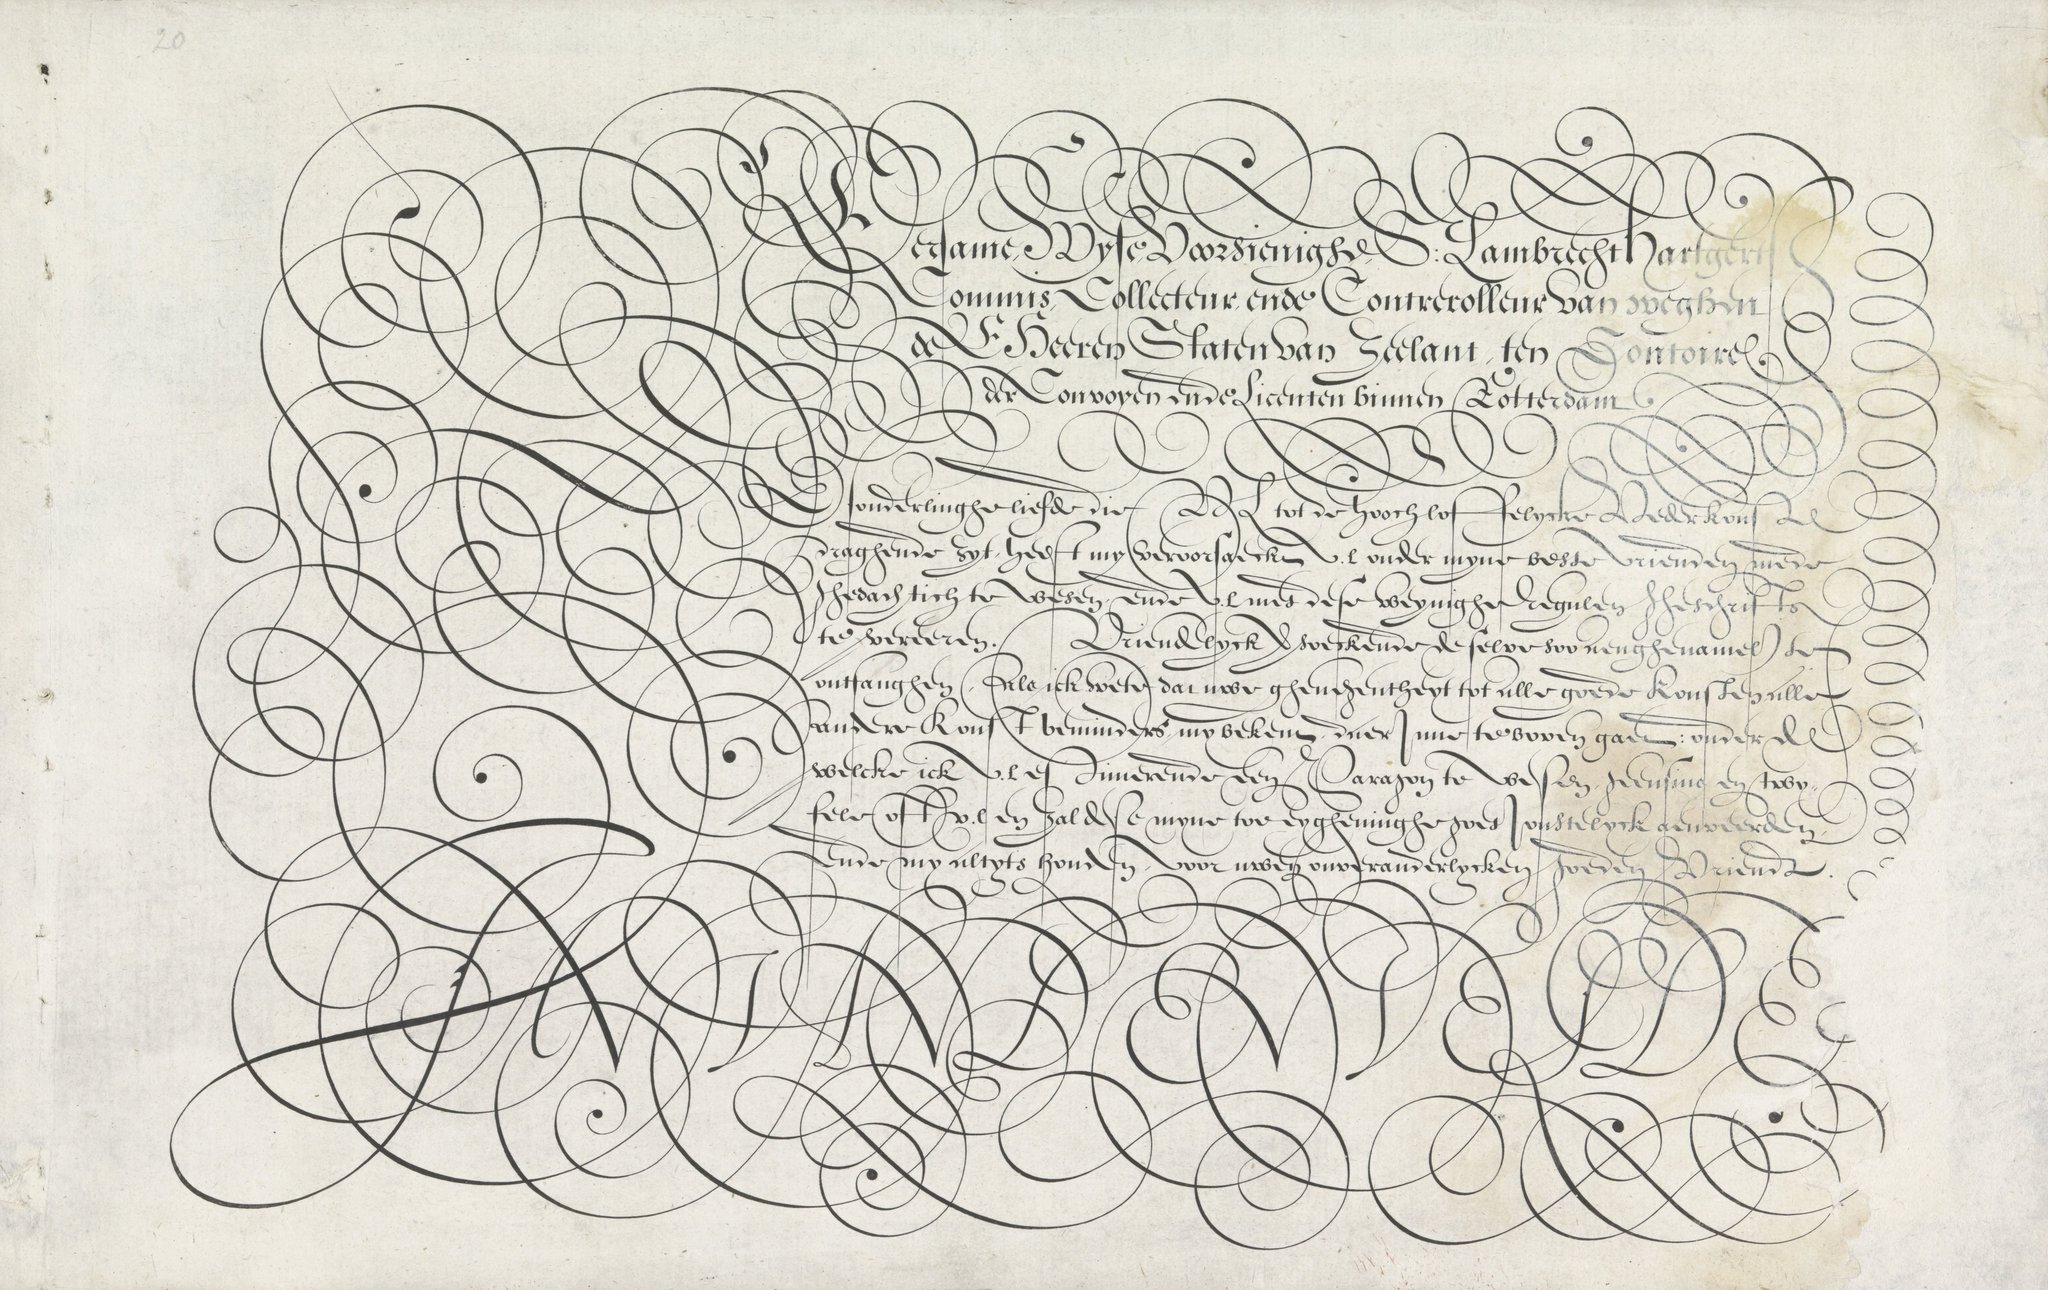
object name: ornament print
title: Spieghel der schrijfkonste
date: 1605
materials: paper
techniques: engraving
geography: haarlem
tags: calligraphy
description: Schrijfvoorbeeld met de aanhef: Eersame wyse voorsienighe S. Lambrecht Hartgerts Commis, collecteur ende contrerolleur van weghen de E Heeren Staten van Zeelant, ten kontoire der convoyen ende licenten binnen Rotterdam. Daaronder in een andere letter negen regels tekst in het Nederlands: De sonderlinghe liefde ... De tekst is omlijst door krulwerk. Onderaan de naam van Jan van de Velde in hoofdletters. De prent maakt deel uit van een album.